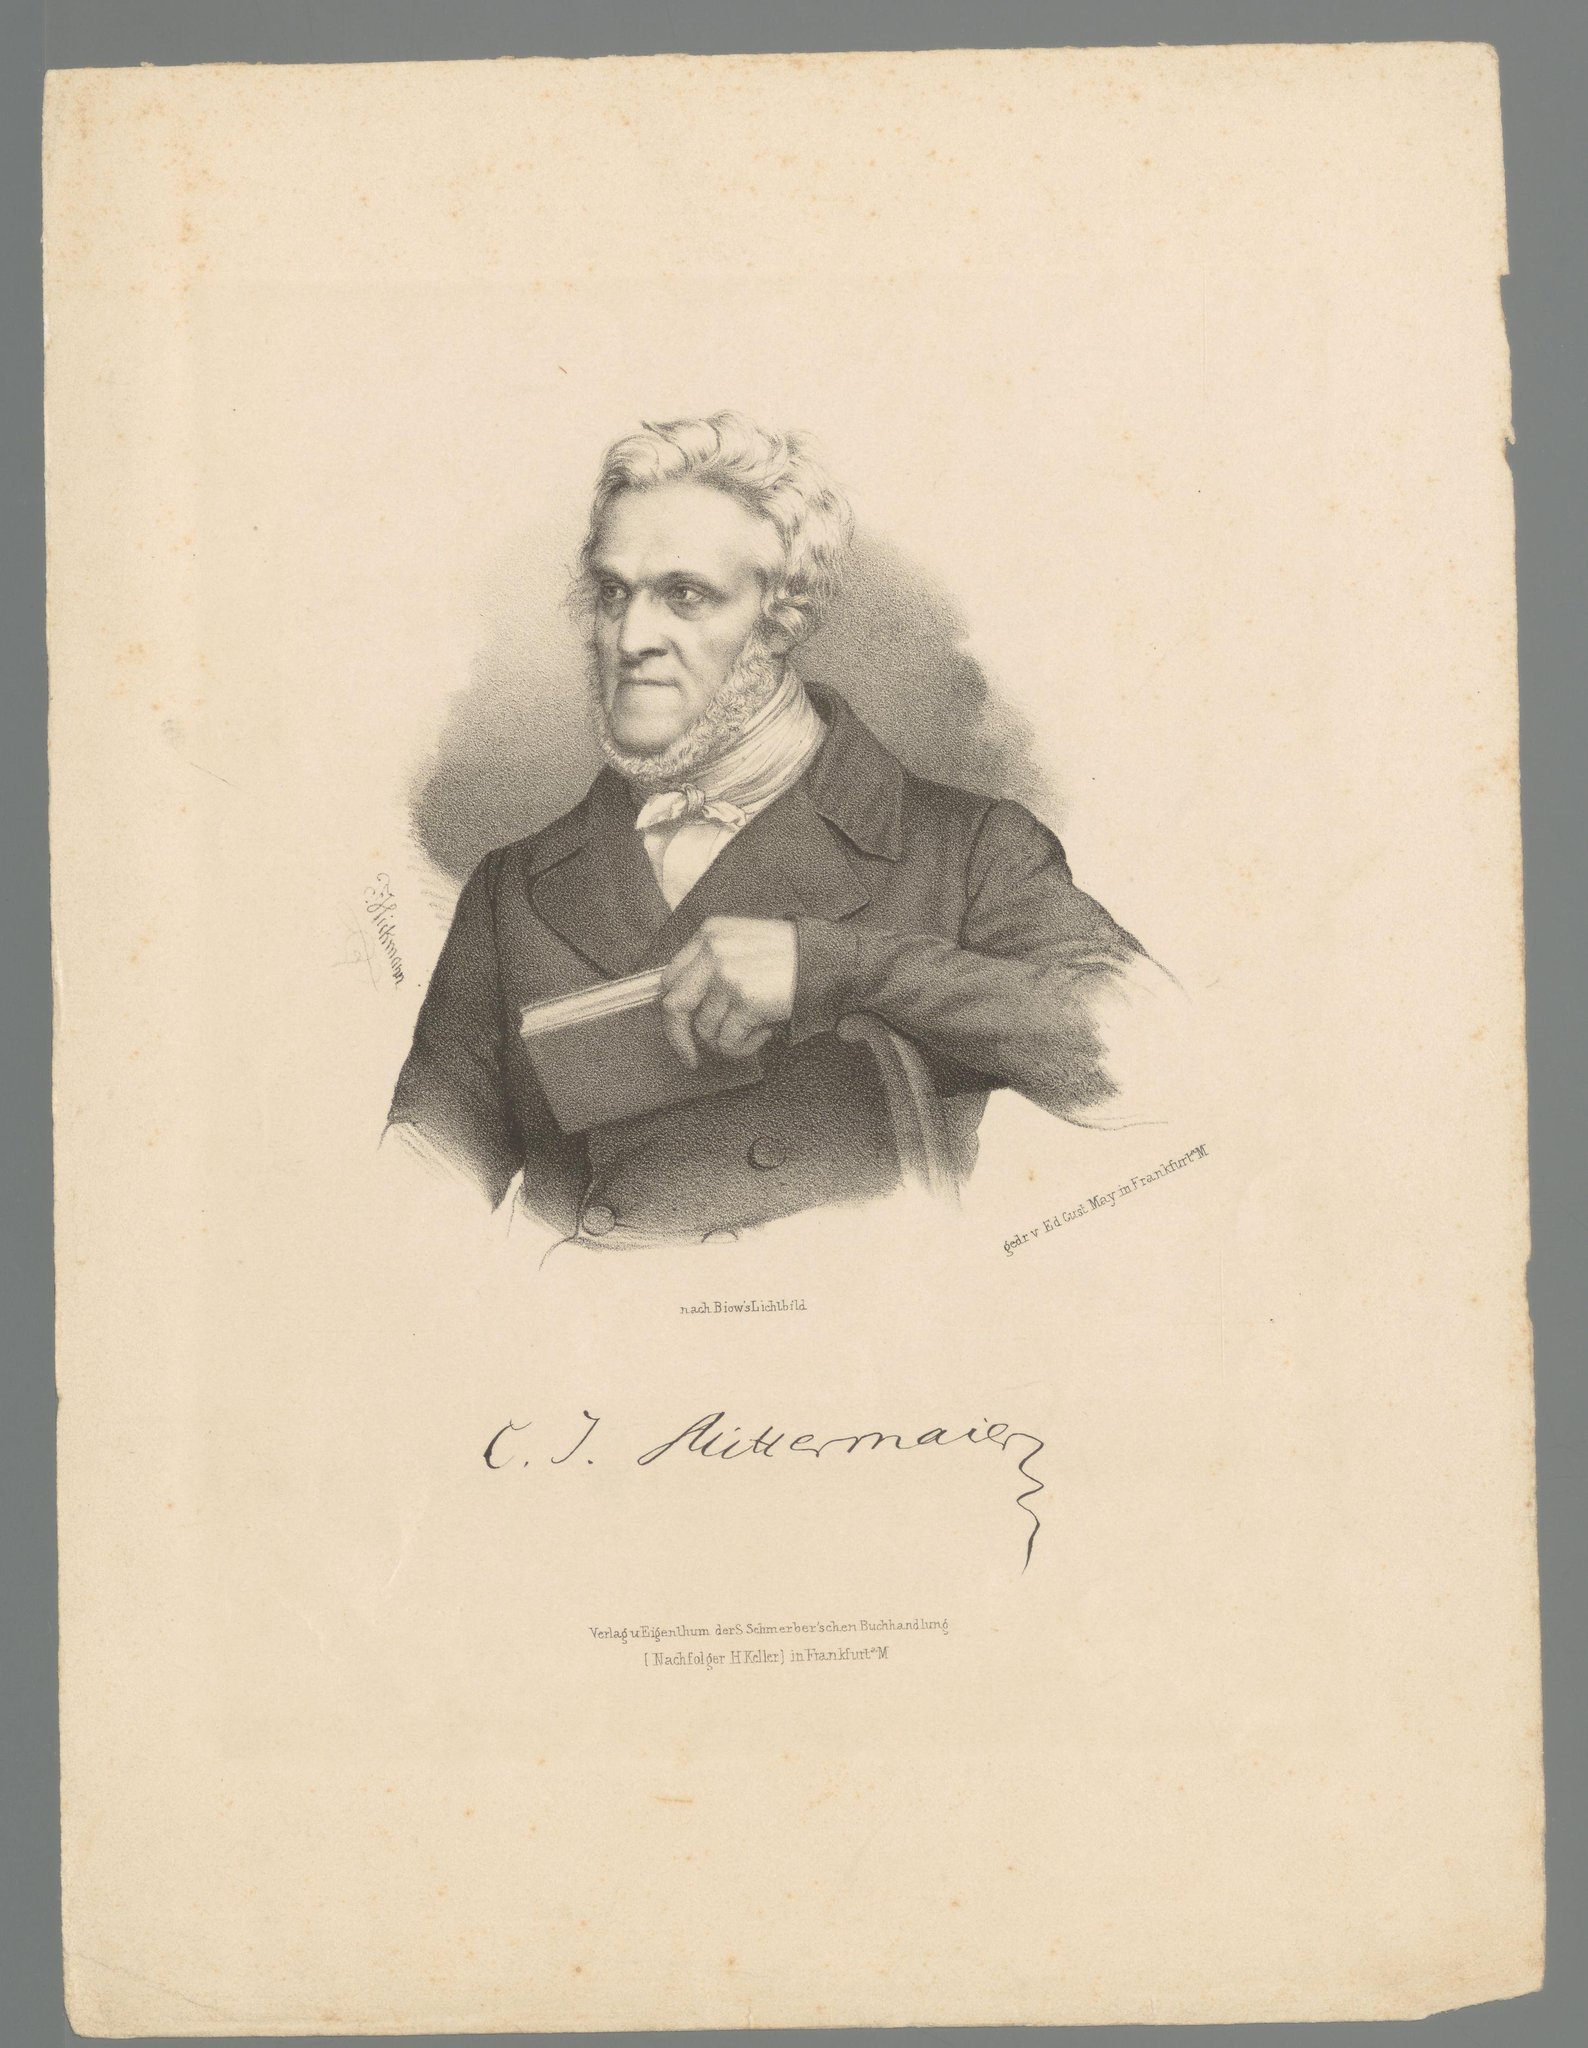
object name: print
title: Portret van Karl Joseph Anton Mittermaier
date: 1830-1900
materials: paper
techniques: lithograph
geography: frankfurt am main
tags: historical persons, law and jurisprudence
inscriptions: collector's mark: Lugt 2228